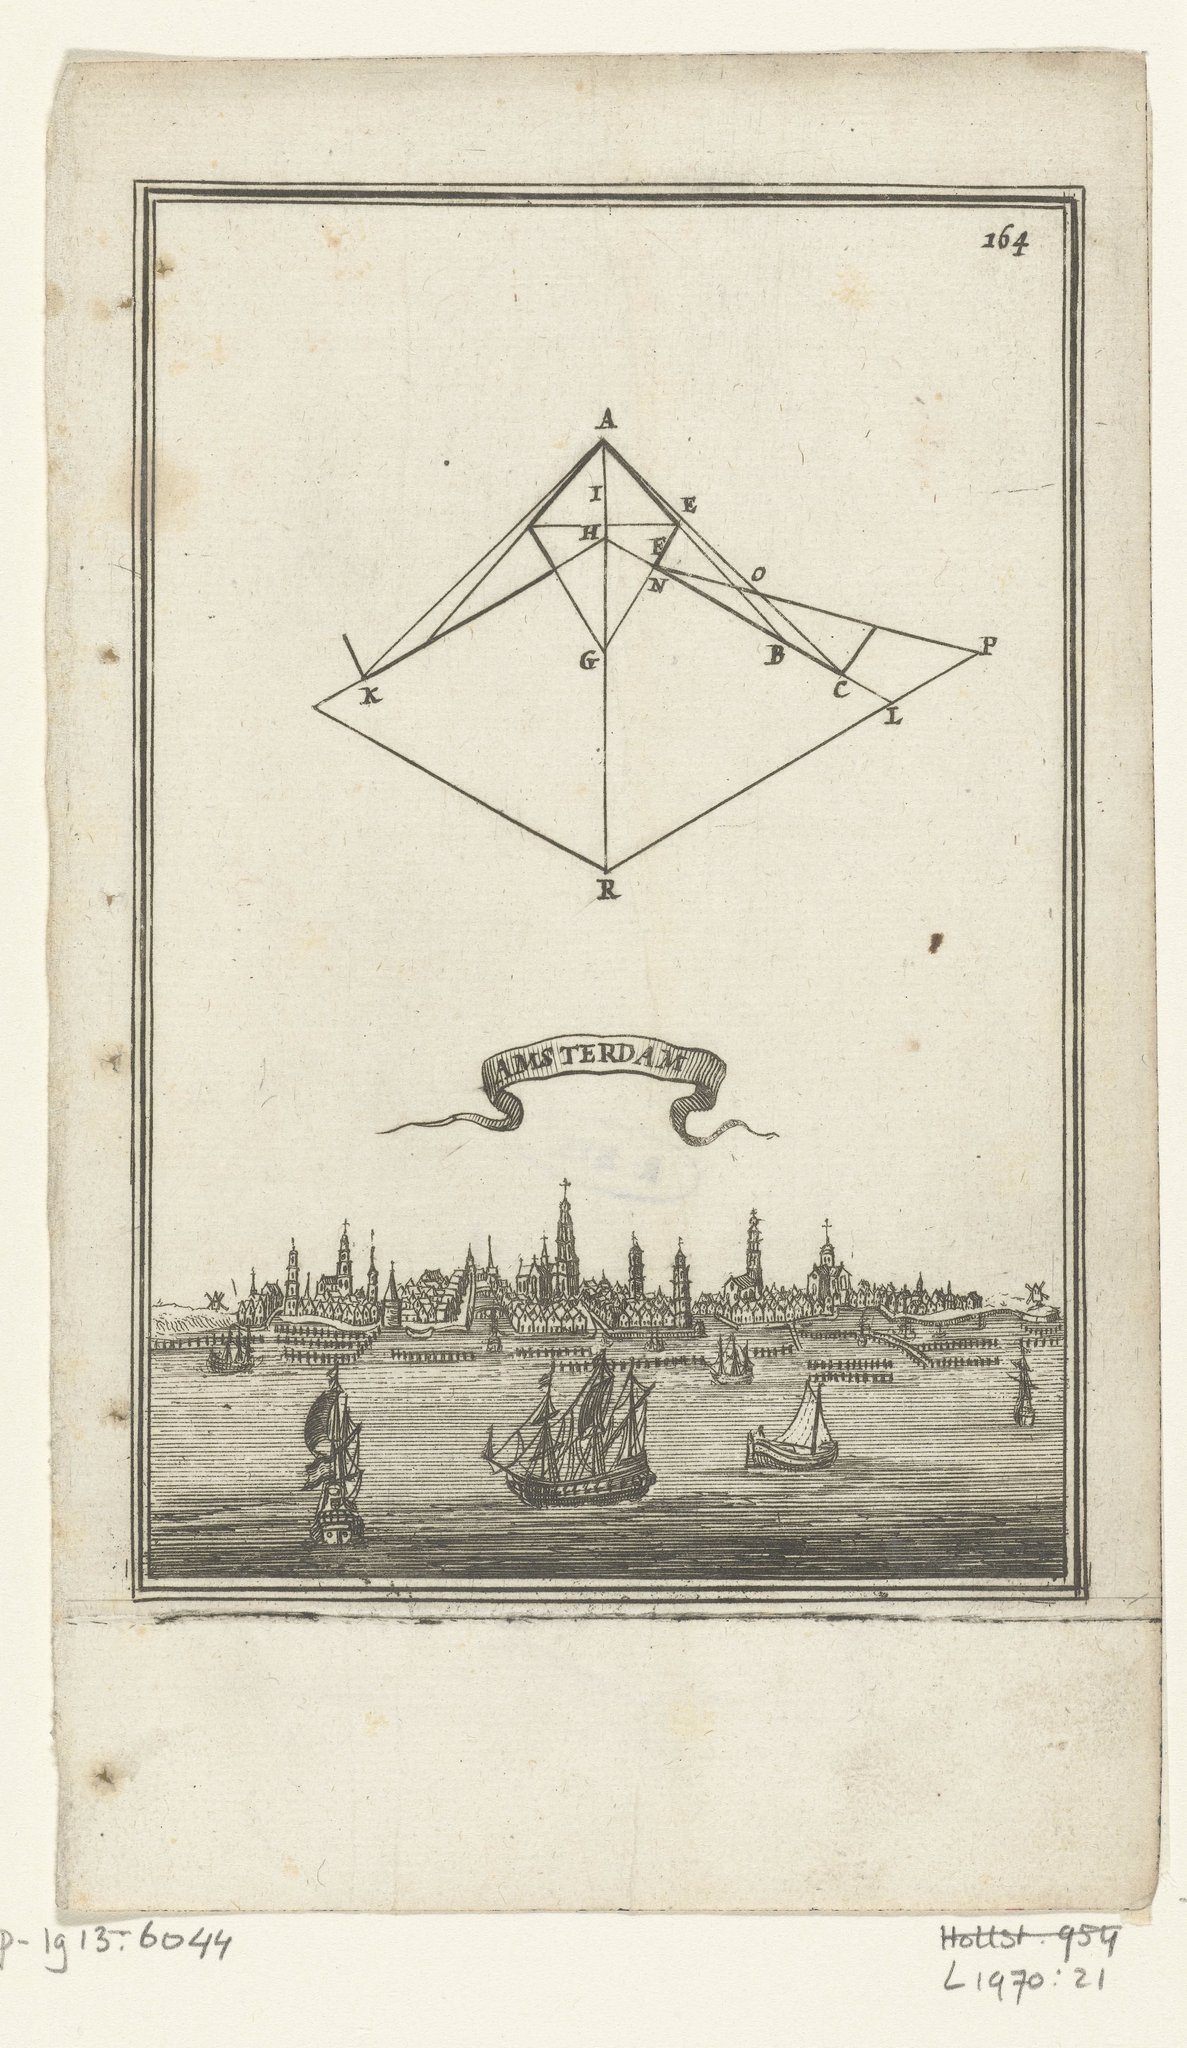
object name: book illustration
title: Illustratie voor 'Den Arbeid van Mars' van Allain Manesson Mallet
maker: romeyn de hooghe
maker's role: draughtsman, goldsmith, painter, print maker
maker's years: 1645-1708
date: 1672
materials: paper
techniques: etching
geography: amsterdam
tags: landscapes with waters, waterscapes, seascapes (in the temperate zone), ships (in general), fortifications, military engineering, prospect of city, town panorama, silhouette of city, mathematics, amsterdam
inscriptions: collector's mark: Lugt 2228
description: Wiskundige figuur. Daaronder een gezicht op een stad aan een water (Amsterdam). In de hoek rechtsboven het cijfer 164 (= het nummer van de pagina in het boek waartegenover de illustratie geplaatst is).